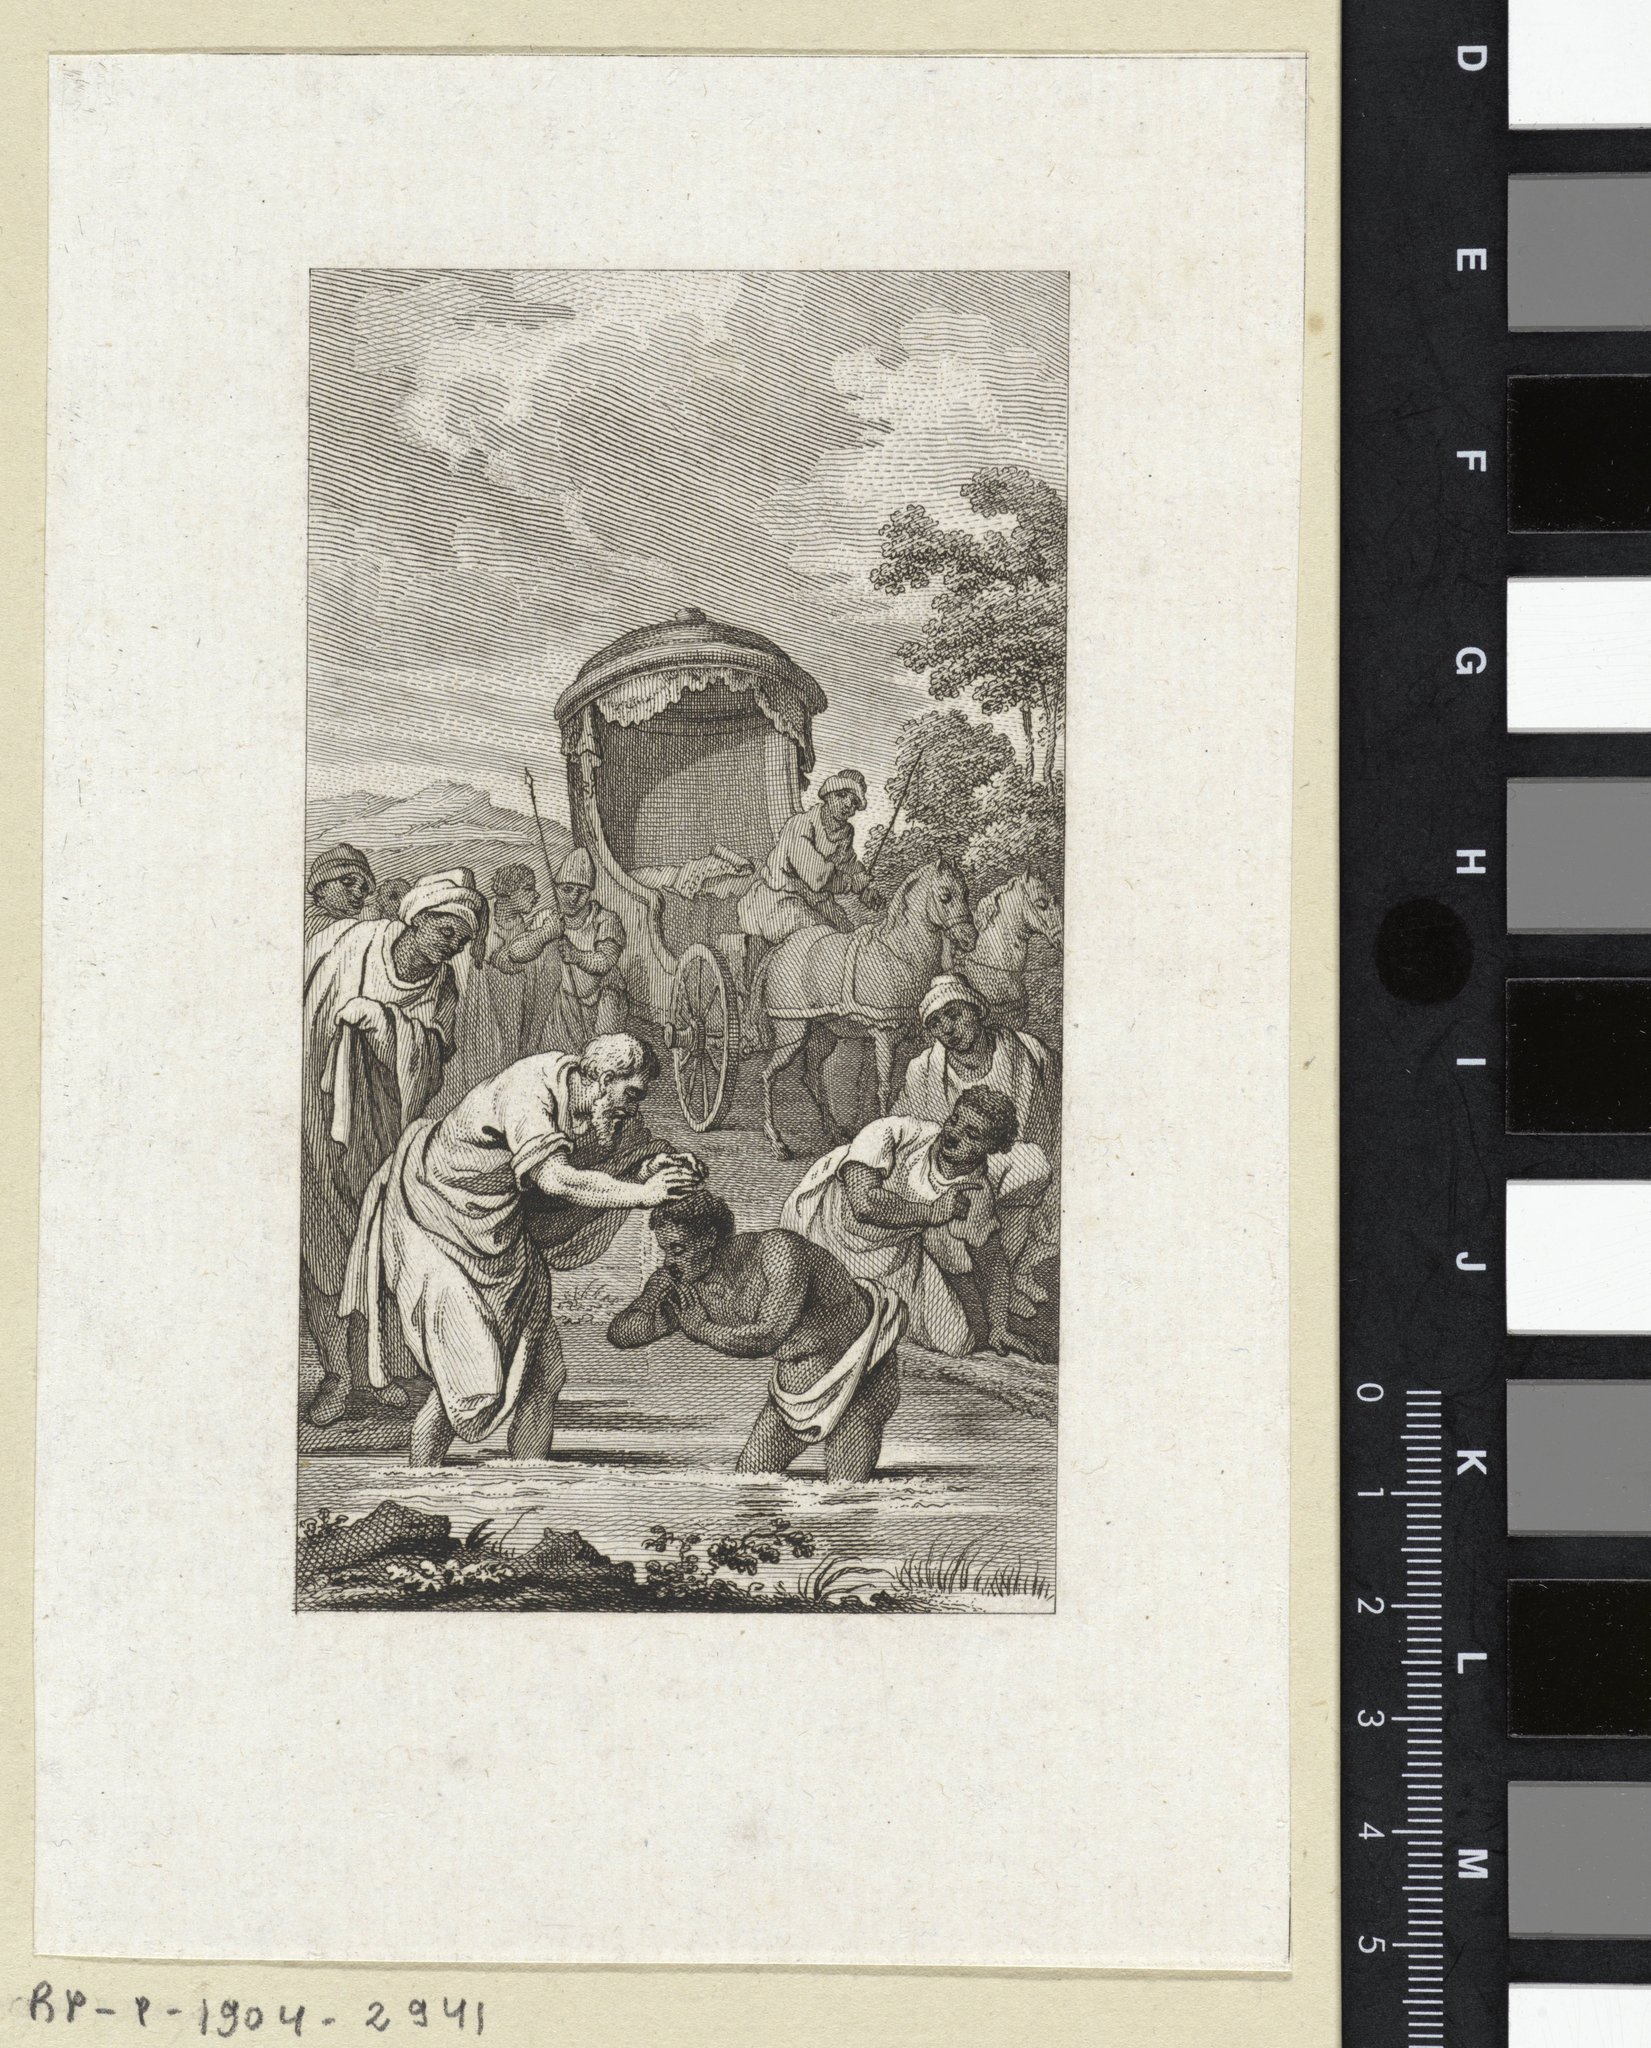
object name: print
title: Doop van de eunuch door de apostel Filippus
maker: reinier vinkeles (i)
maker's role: draughtsman, print maker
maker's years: 1741-1816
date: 1751-1816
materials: paper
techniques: engraving, etching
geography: amsterdam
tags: philip baptizes the eunuch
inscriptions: collector's mark: Lugt 2228